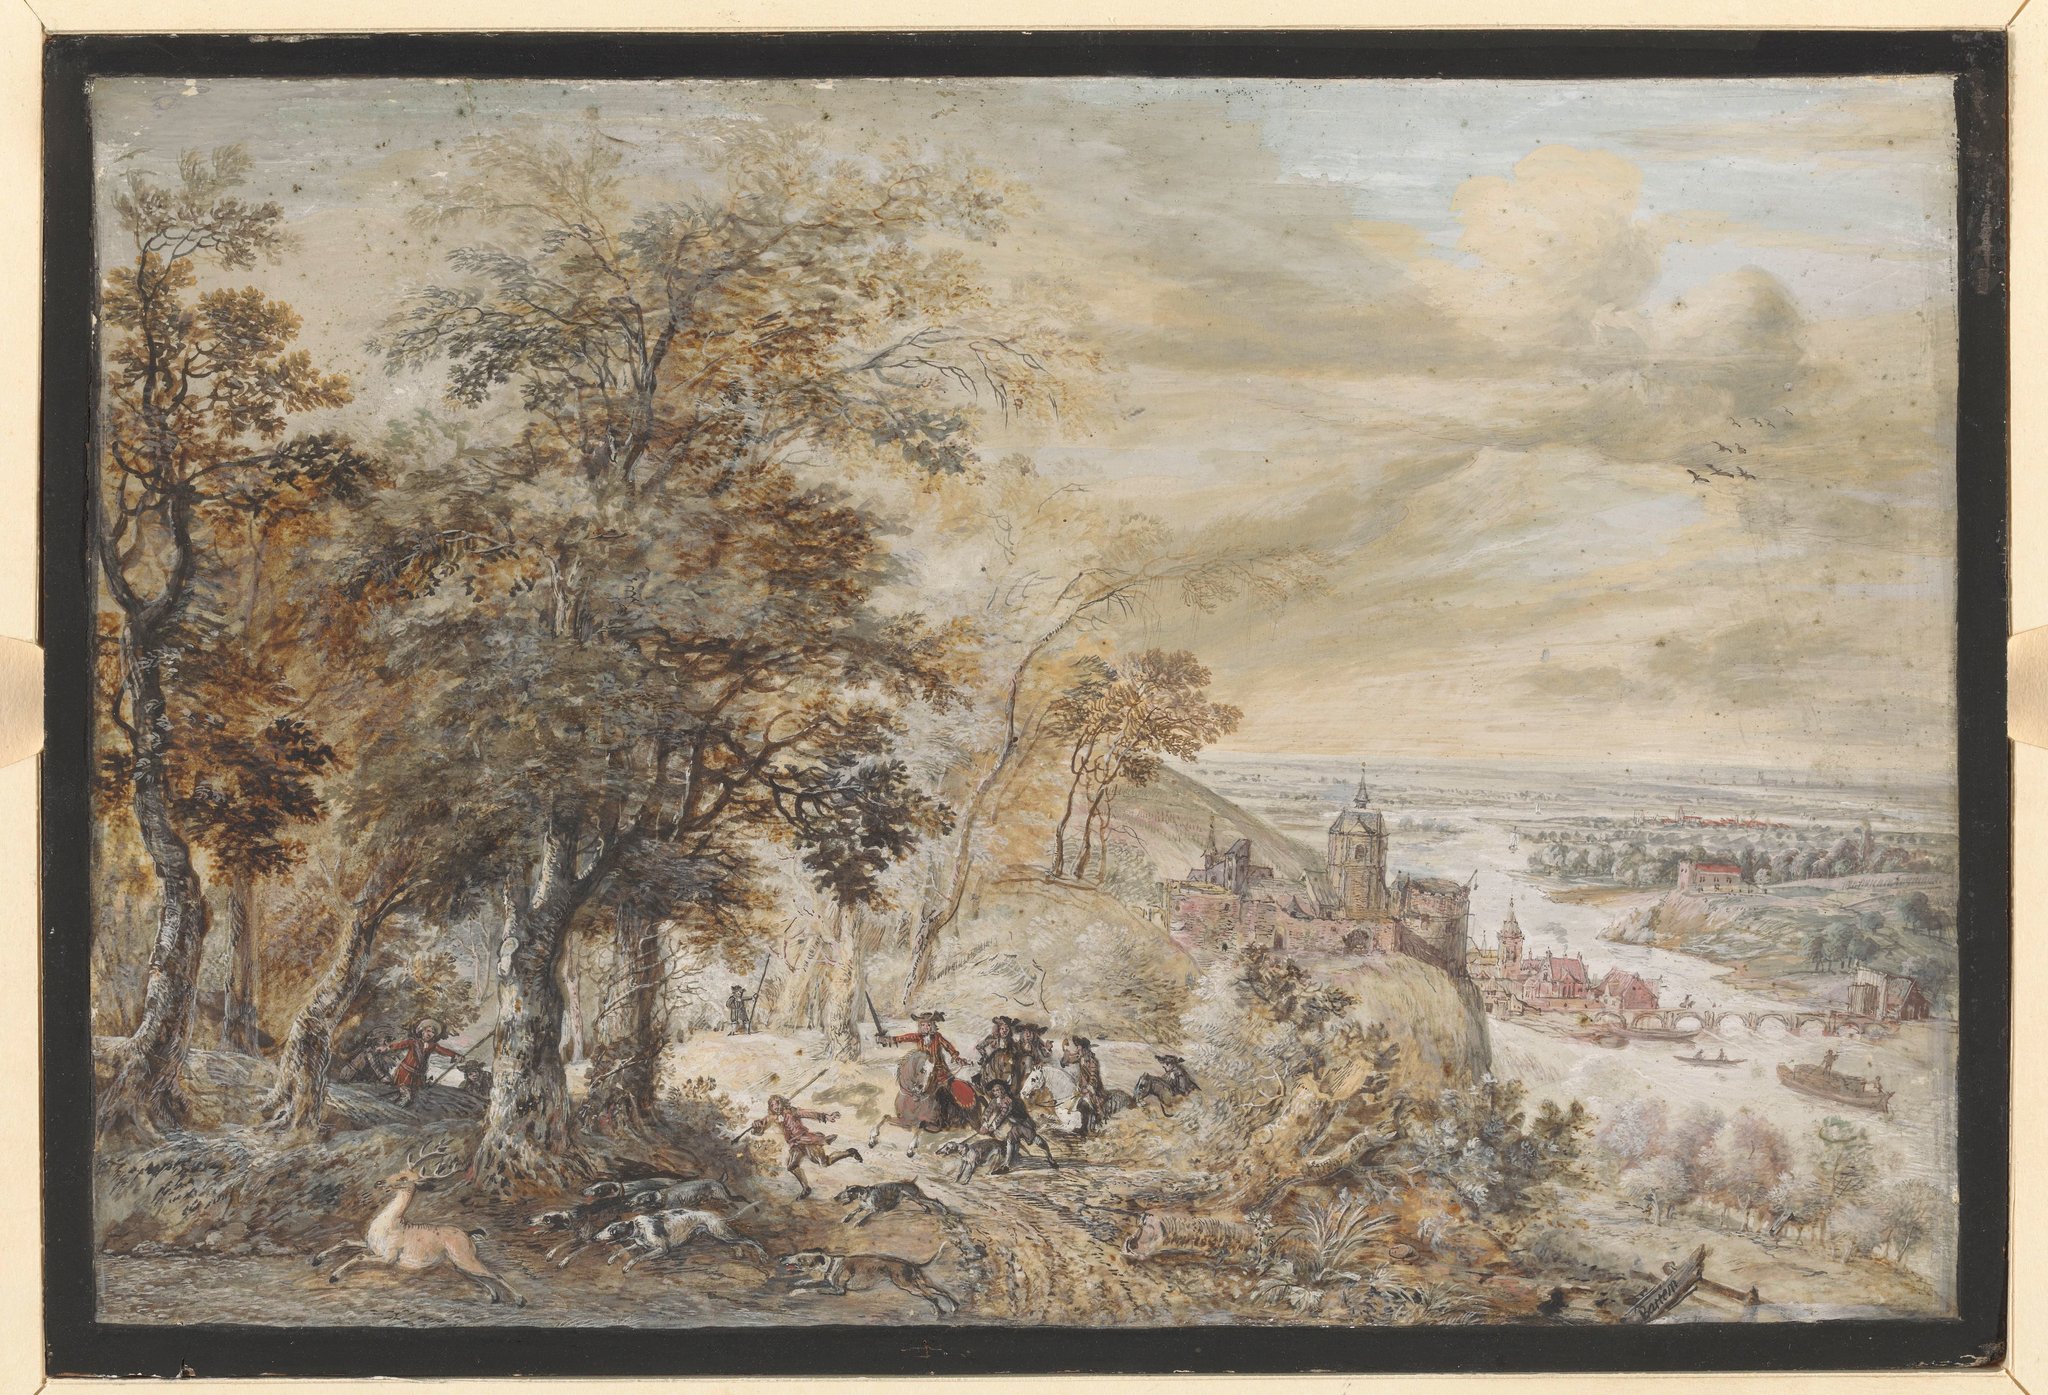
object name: drawing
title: Vorstelijke jachtpartij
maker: gerrit battem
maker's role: draughtsman, painter, print maker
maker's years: 1636-1684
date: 1646-1684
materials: paint, gouache, panel, parchment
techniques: brush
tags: stag-hunting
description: Op de voorgrond een hert achtervolgd door een meute, in het midden een vorstelijk persoon te paard die het wild achtervolgt met begeleiders. Rechts een rivier in een dal met een slot op de heuvels boven een stad.